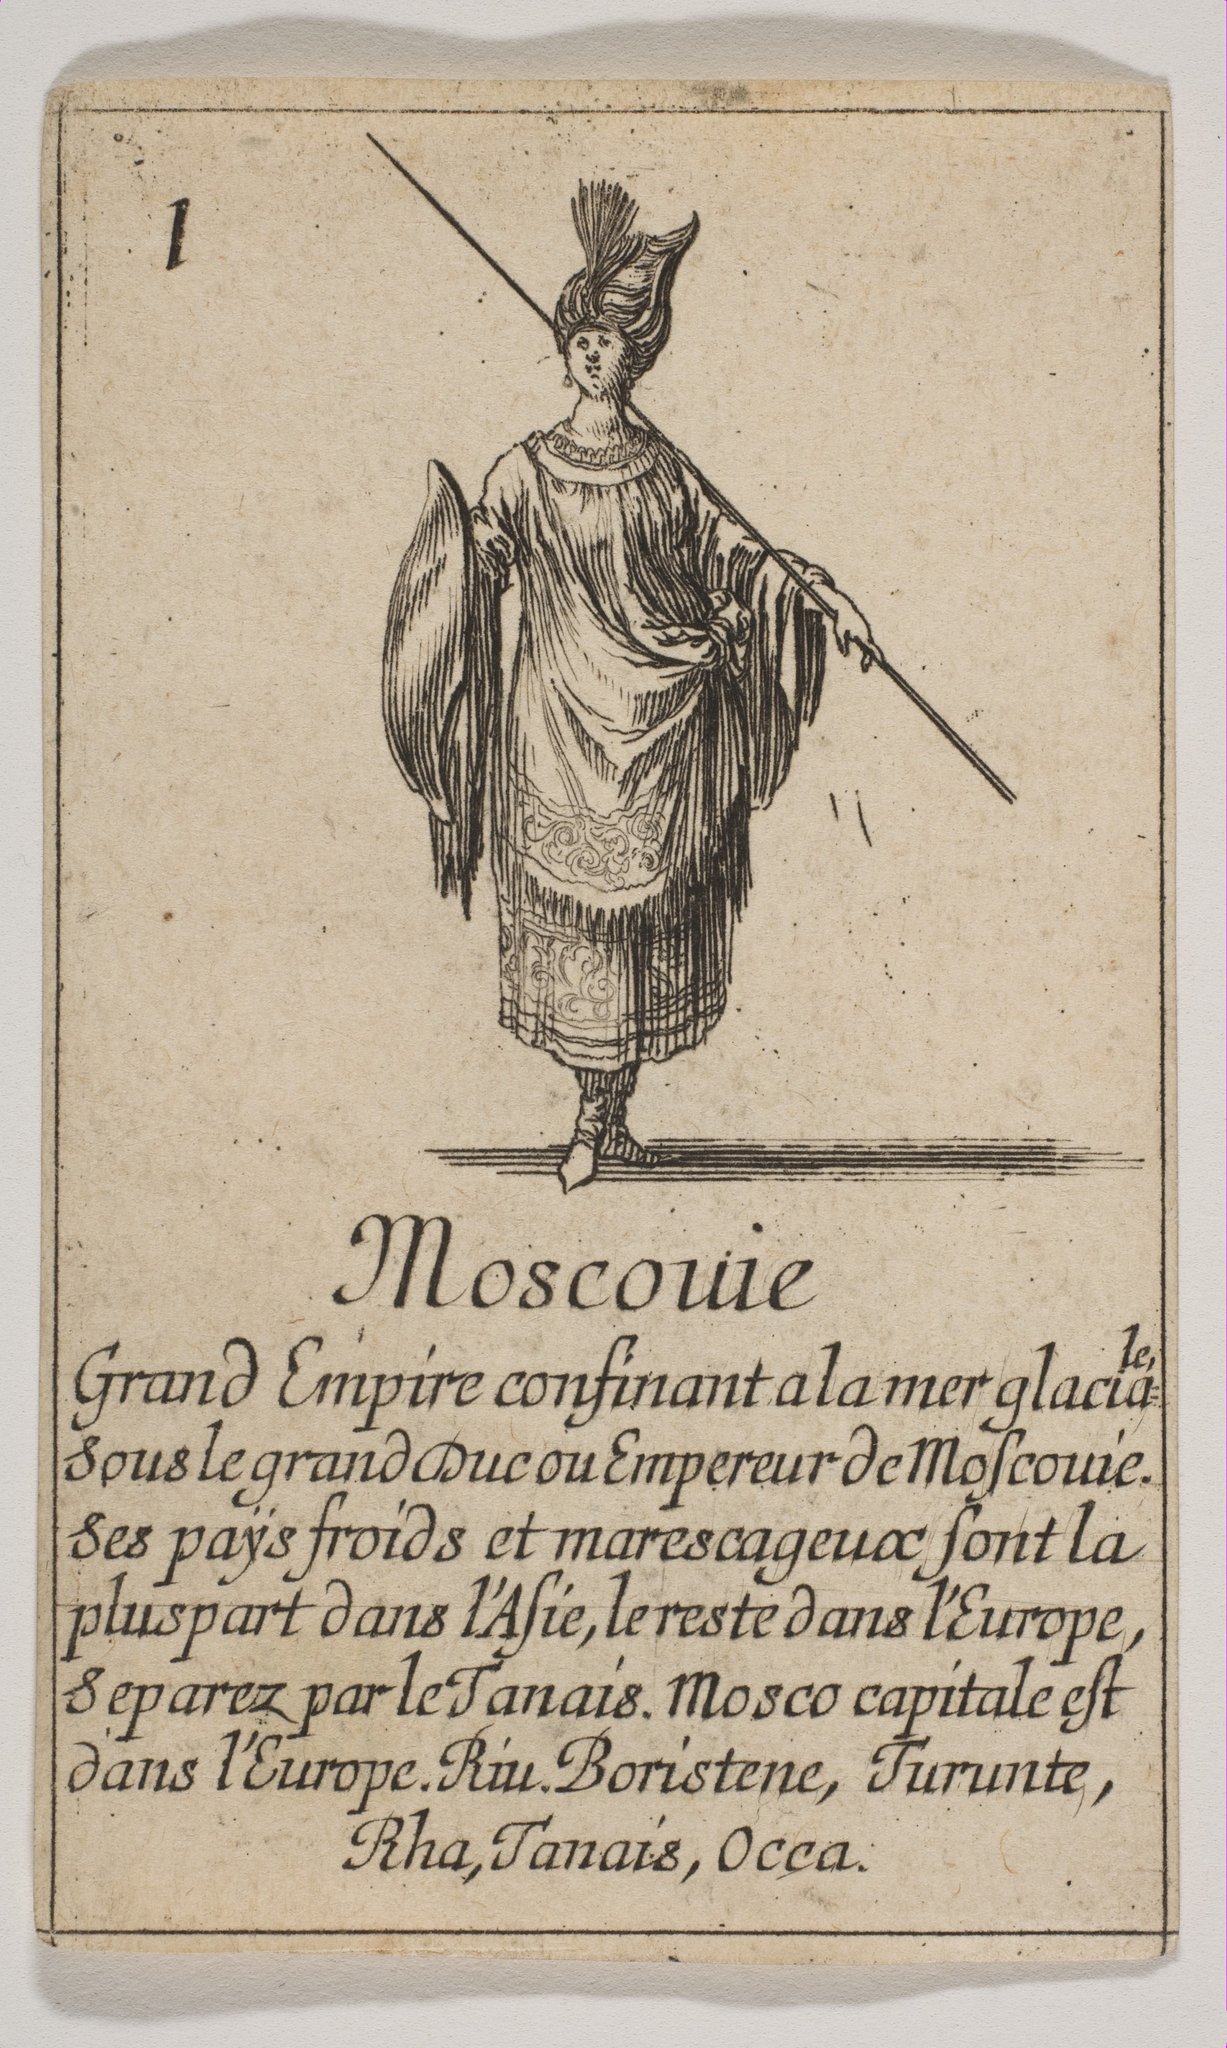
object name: print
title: Moscovie, from "Jeu de la Géographie"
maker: stefano della bella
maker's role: artist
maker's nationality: italian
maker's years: 1610-1664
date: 1644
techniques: etching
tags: women